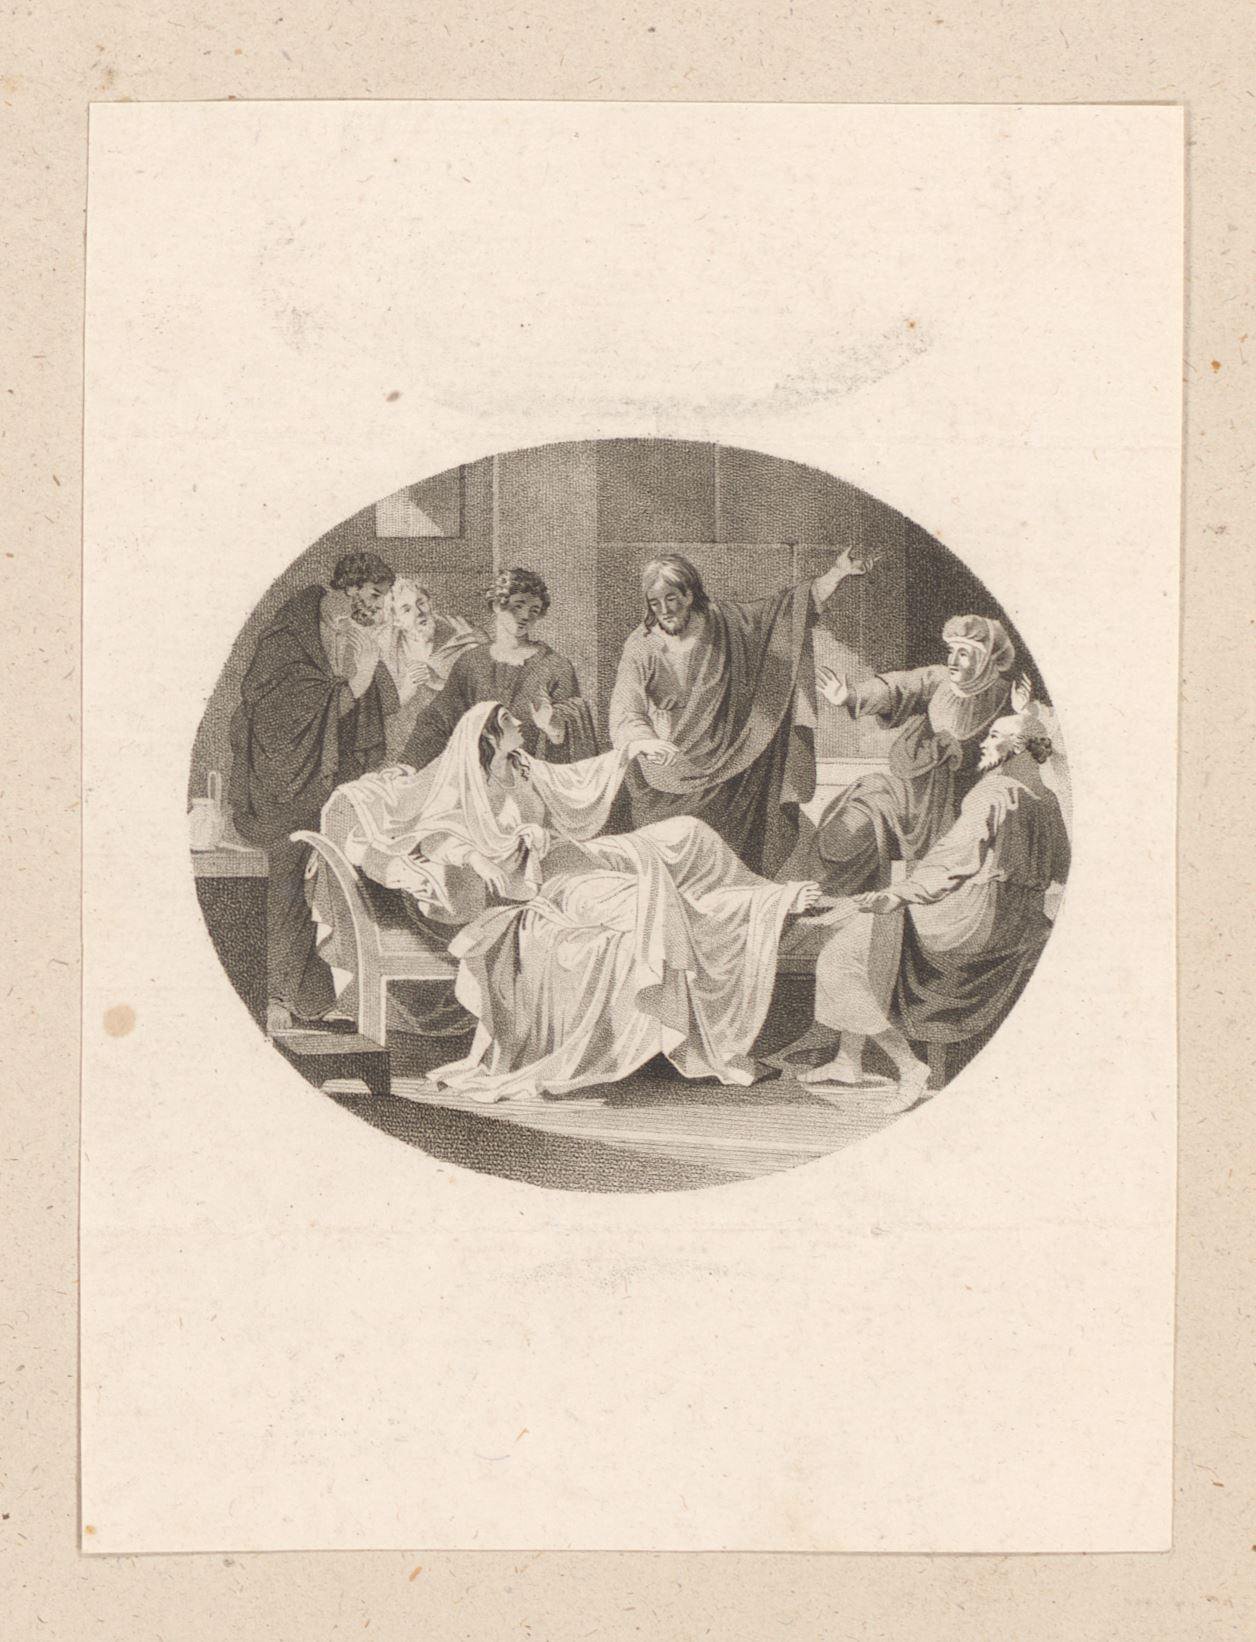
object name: book illustration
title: Opstanding van Cidli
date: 1804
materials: paper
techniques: engraving, etching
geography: haarlem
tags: raising from the dead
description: Gebruikt als boekillustratie in: Adriaan Pietersz. Loosjes. Semida en Cidli of de Hope der opstanding. Haarlem: A. Loosjes, 1804. Heruitgegeven in 1816.